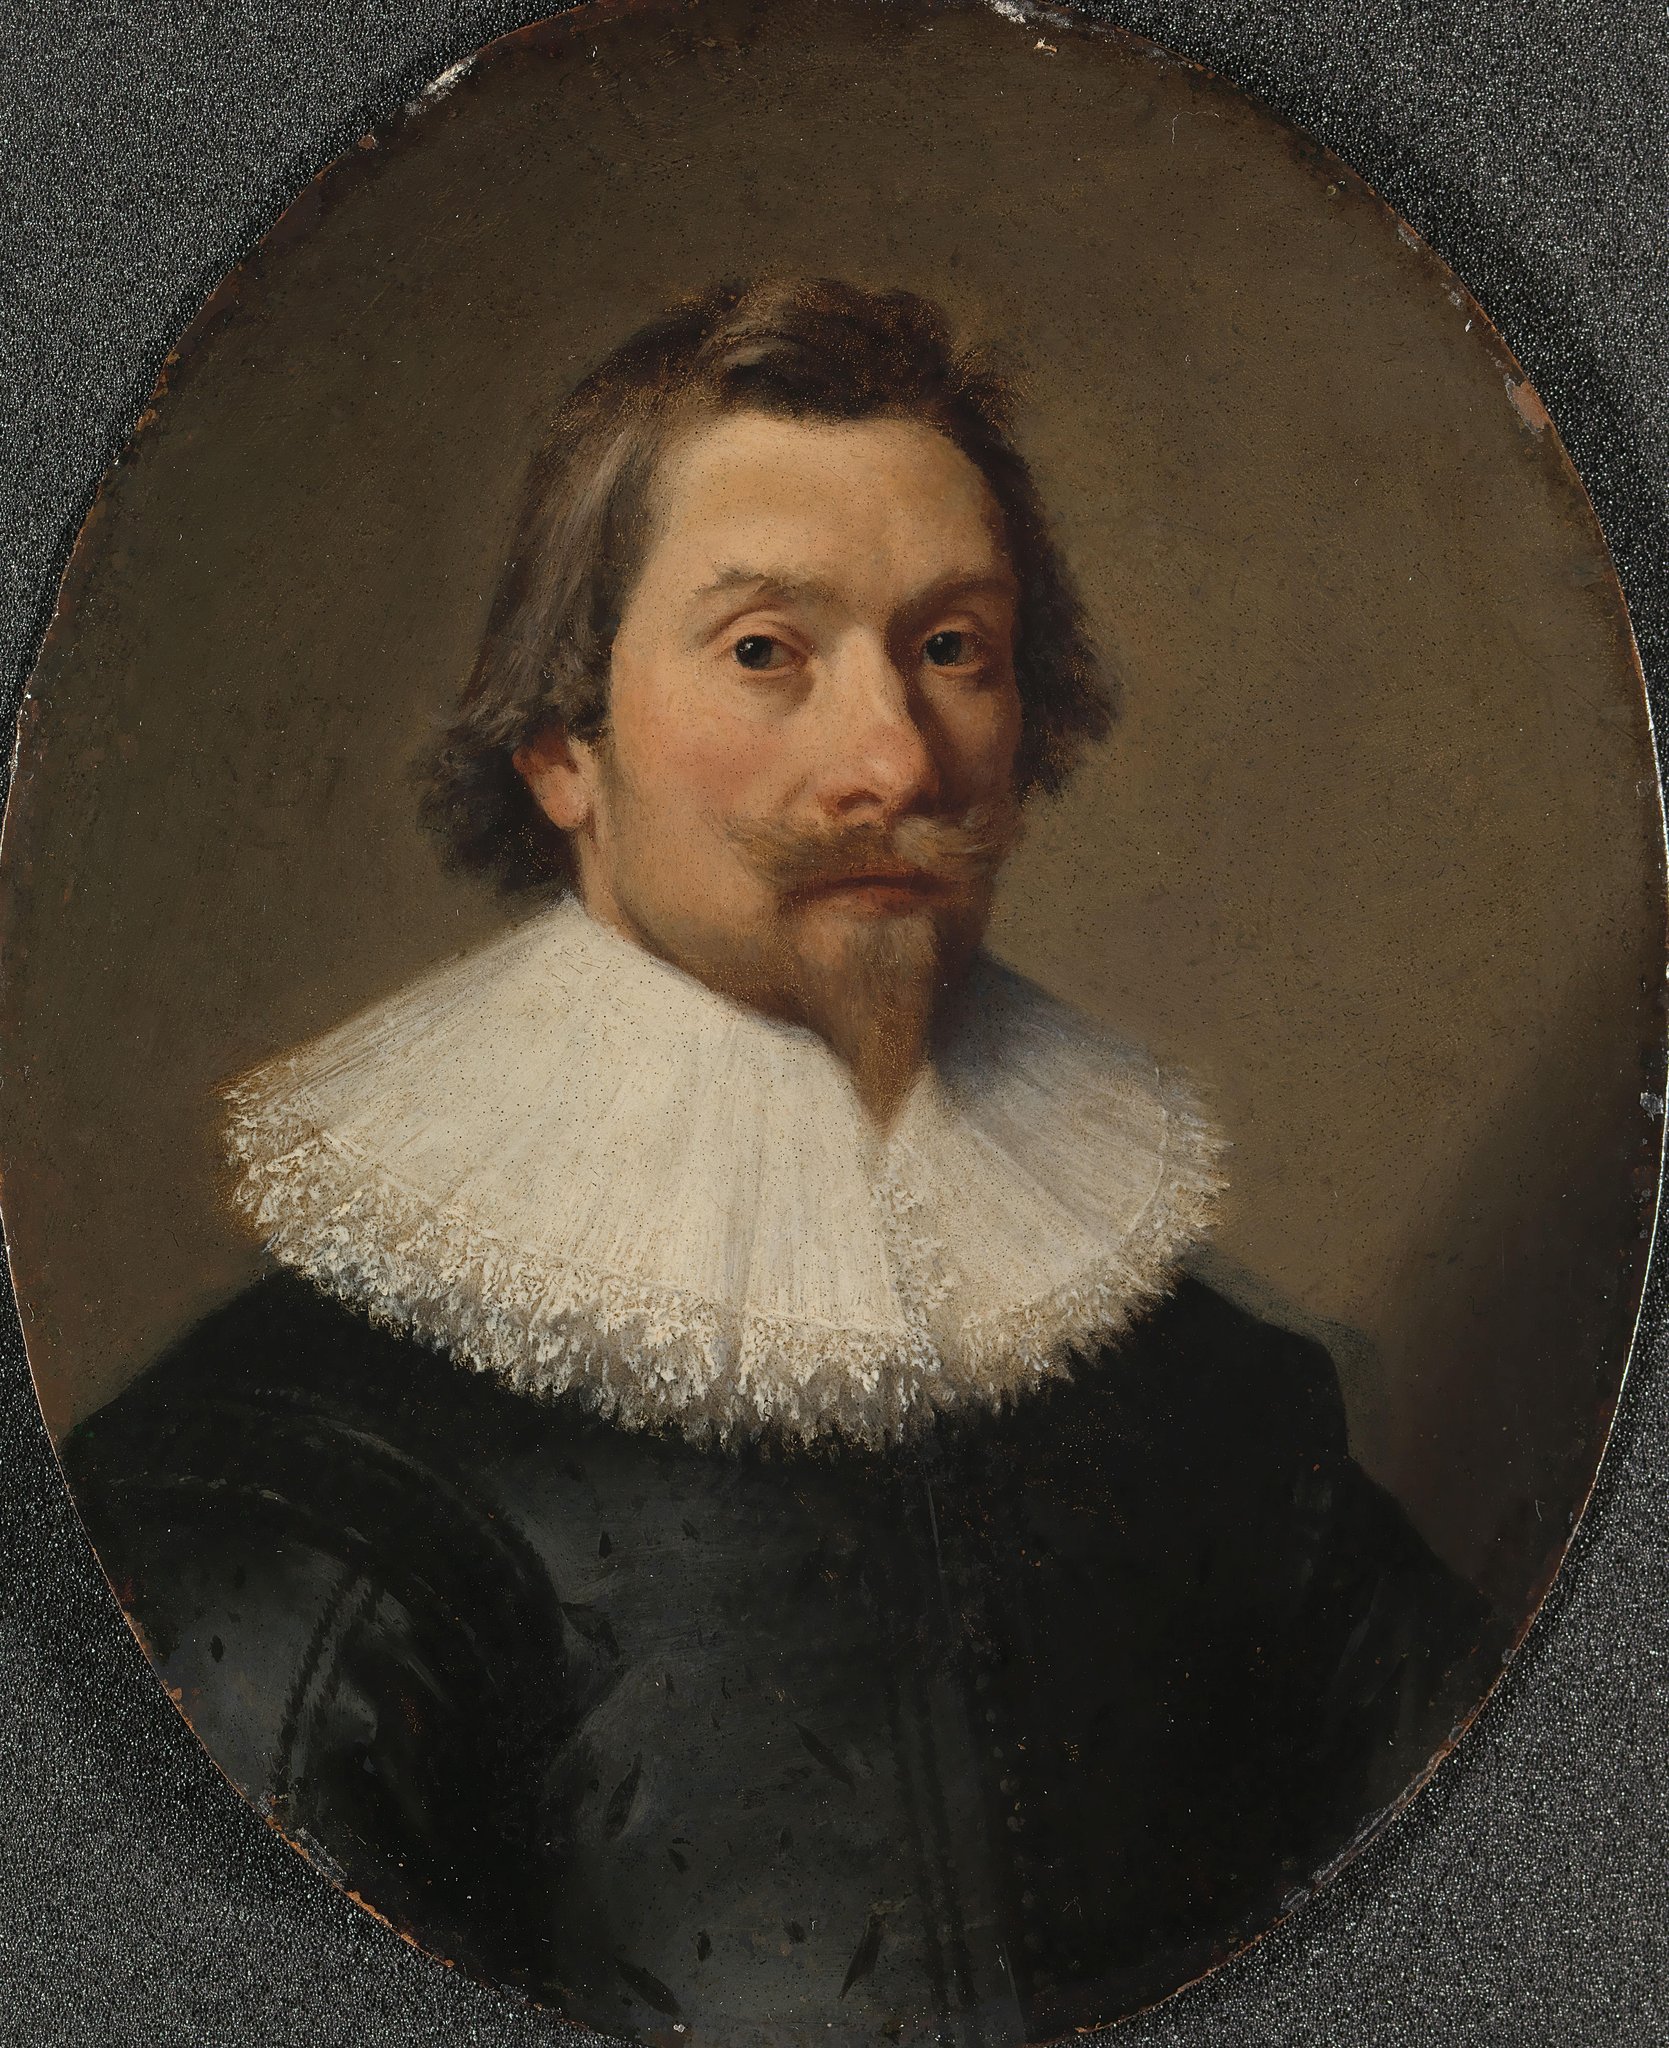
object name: painting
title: Portrait of Cornelis Samuelsz van Esch (1594/95-1656)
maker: Anonymous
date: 1632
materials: copper, oil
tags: dordrecht, historical persons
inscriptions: inscription and date, centre left, the sitter's age inscribed twice: ‘Æ[...] 37 / 1632’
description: Portret van Cornelis Samuelsz. van Esch (1594/95-1656). Buste naar rechts. Onderdeel van een serie van zeven ovale portretten van Cornelis Samuelsz van Esch, zijn vrouw Josina Jansdr de Carpentier, hun drie dochtertjes en twee zoontjes (SK-A-1747-A/G).